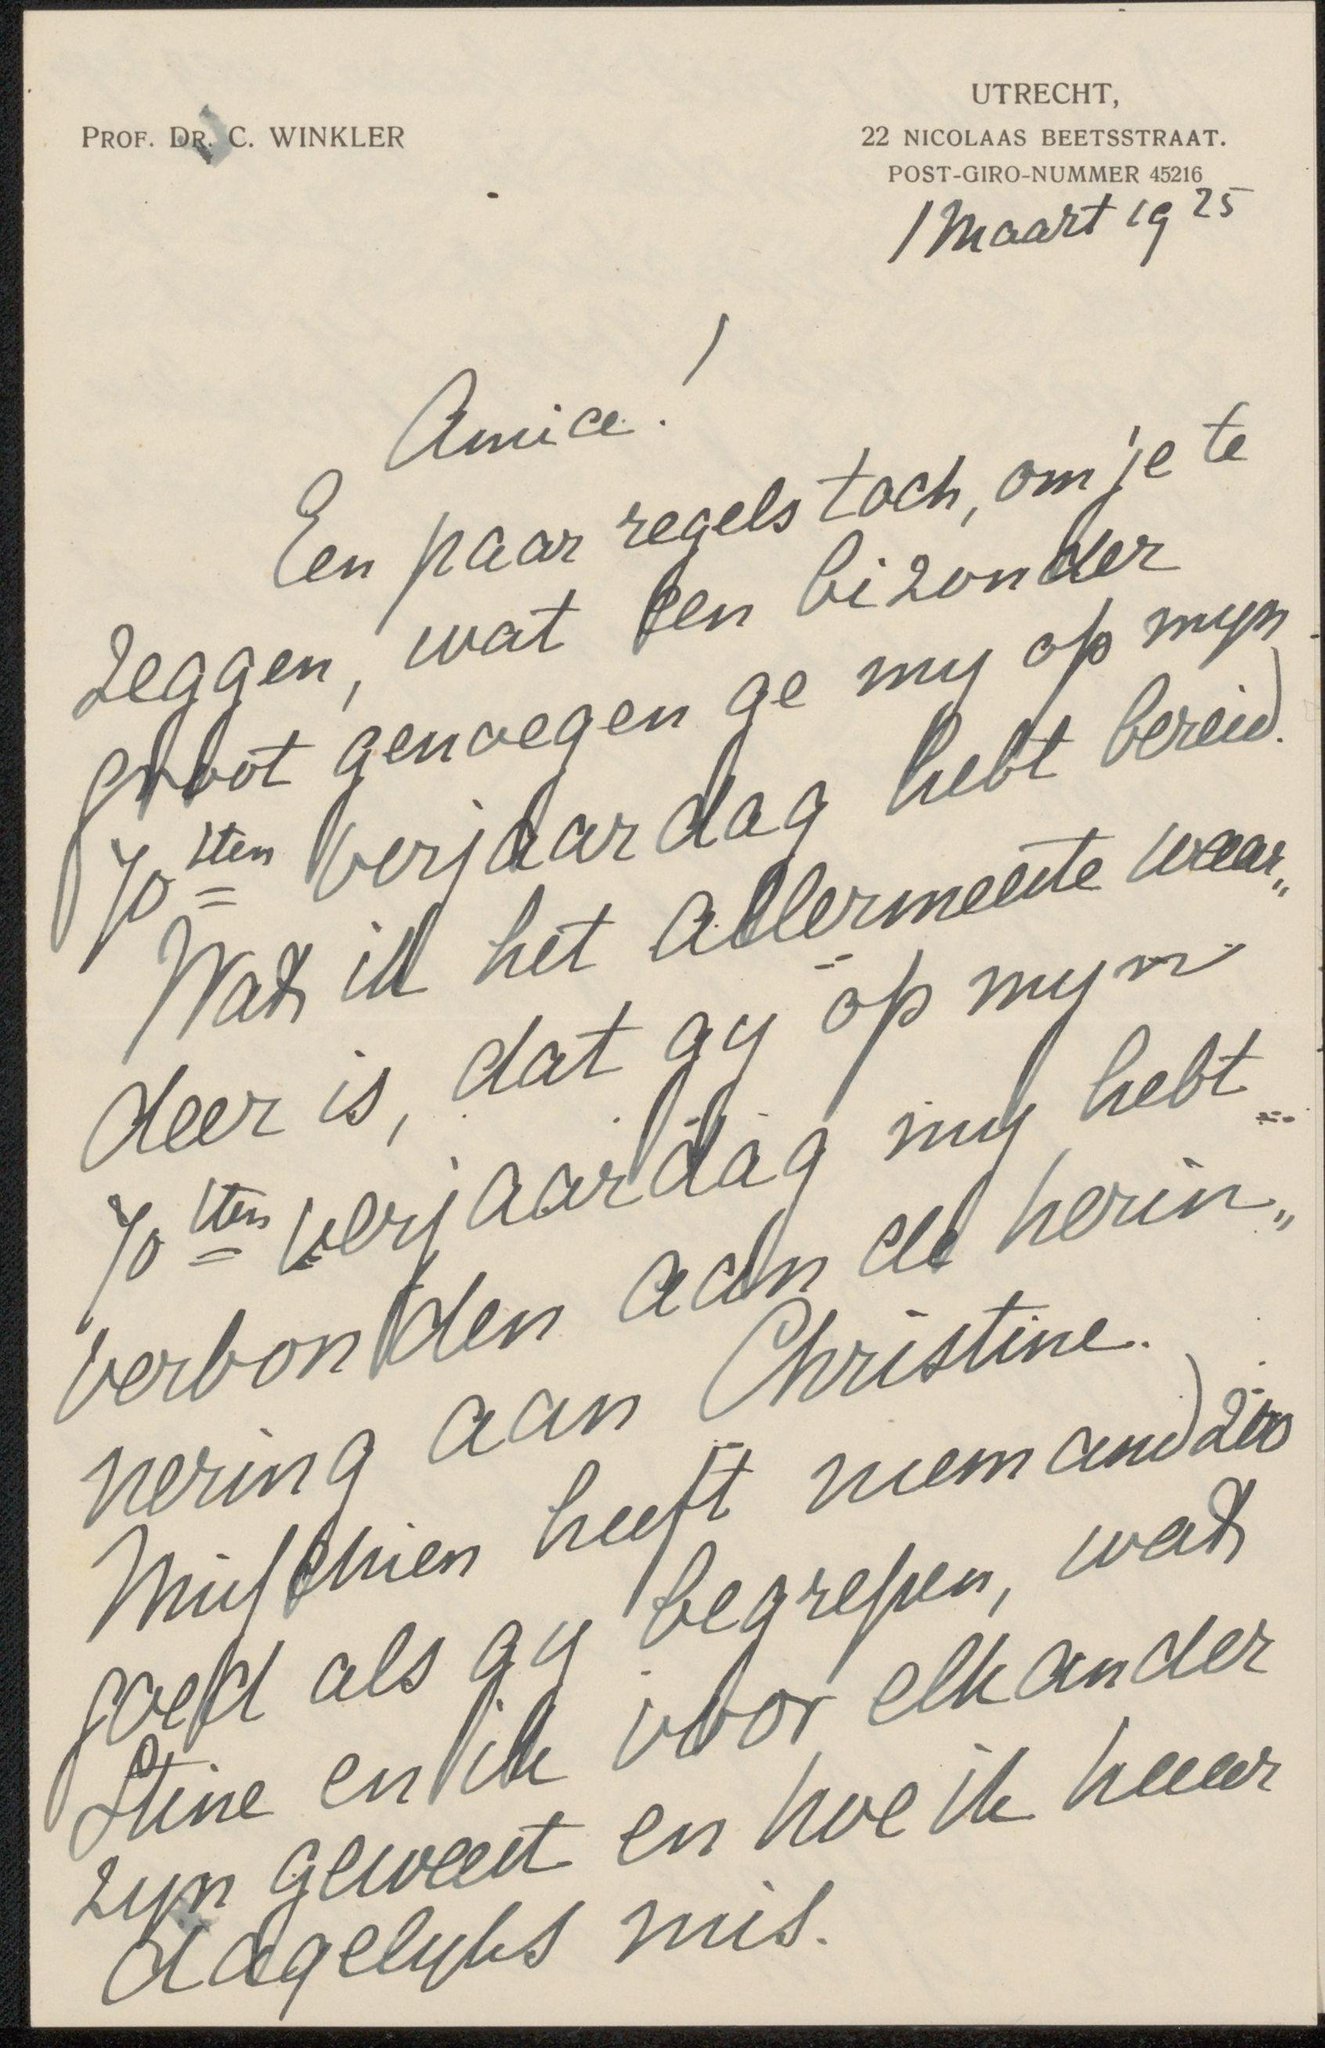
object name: letter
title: Brief aan Jan Veth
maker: cornelis winkler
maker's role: hoogleraar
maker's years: 1855-1941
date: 1925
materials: ink, paper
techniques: pen, printing, writing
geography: utrecht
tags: dordrecht, painter, jan veth, passions, emotions, affections, family life, historical persons (portraits and scenes from the life)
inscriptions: collector's mark: ‘RPK’